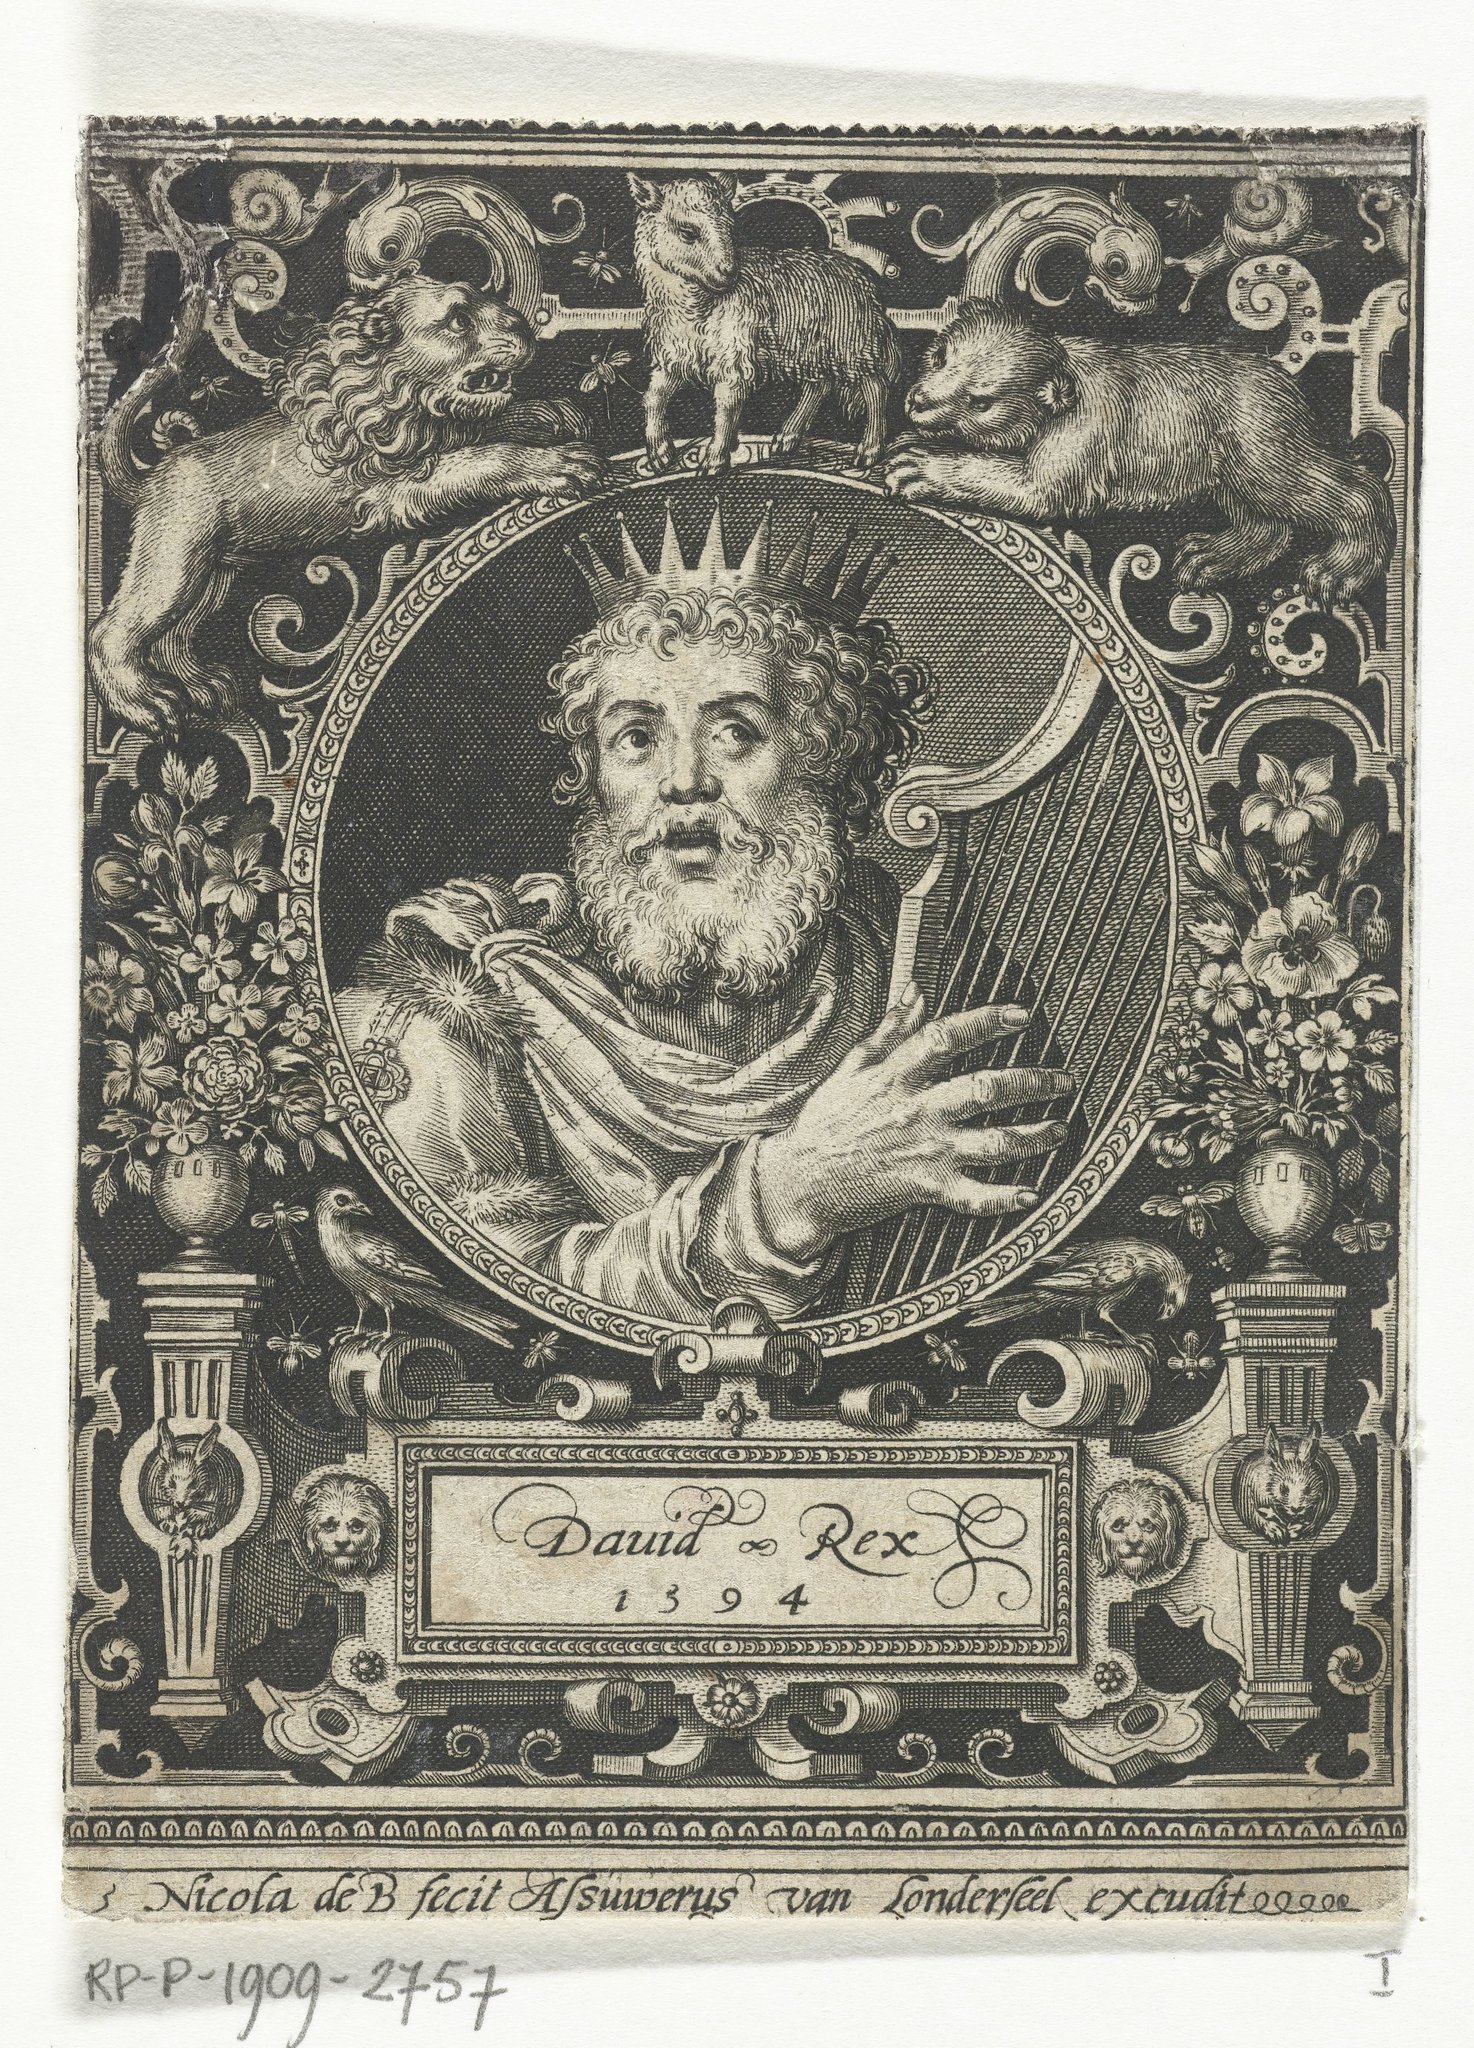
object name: print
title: David Rex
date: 1594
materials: paper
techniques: engraving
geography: netherlands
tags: david (not in biblical context); possible attributes: crown, harp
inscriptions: collector's mark: Lugt 2228, collector's mark: Lugt 2773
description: Portret met buste van Koning David met harp in medaillon binnen rechthoekige omlijsting met ornamenten in de vorm van wilde dieren, een leeuw en beer, en een lam.